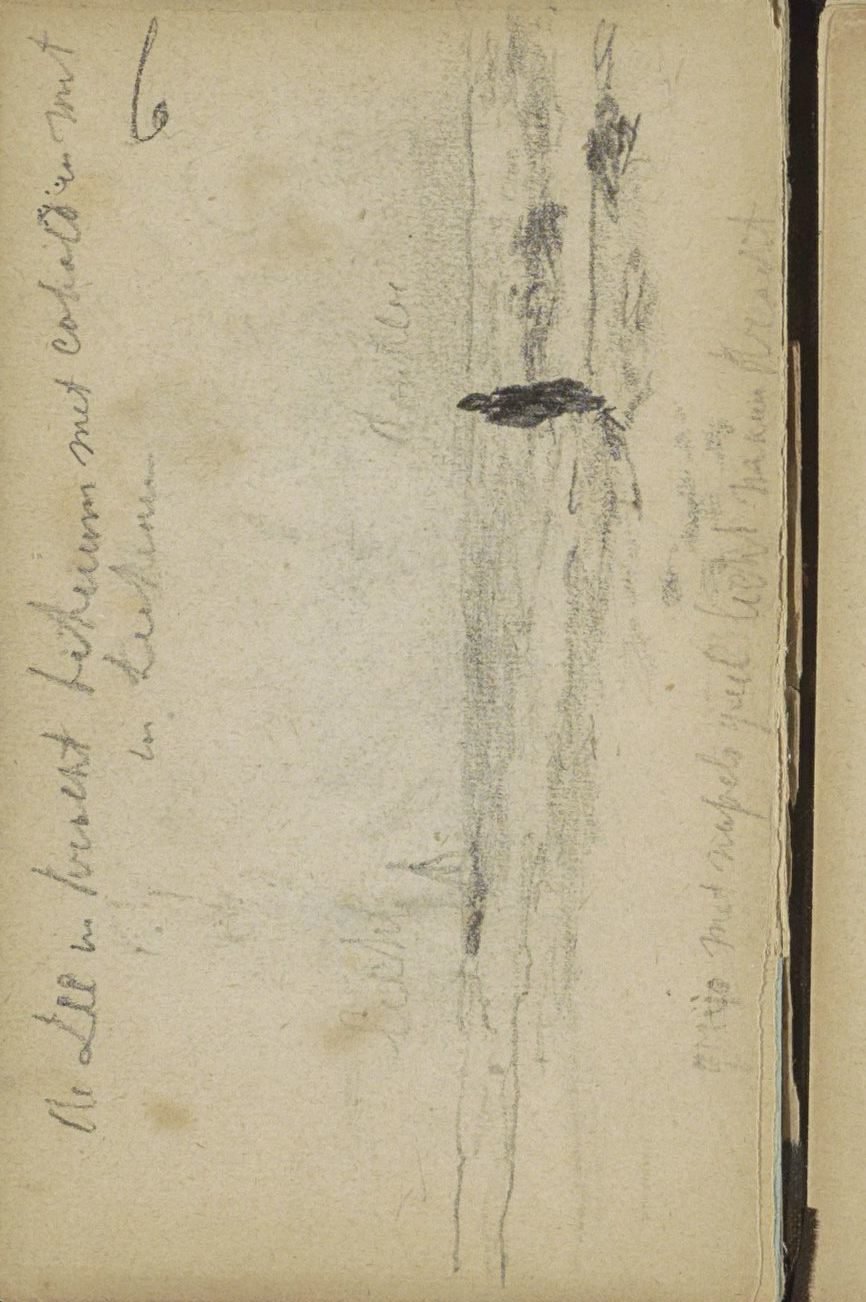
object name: sketchbook leaf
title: Zeegezicht met een figuur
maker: johan hendrik weissenbruch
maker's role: draughtsman, painter, print maker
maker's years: 1824-1903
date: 1834-1903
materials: paper, pencil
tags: sea (seascape) (+ landscape with figures, staffage)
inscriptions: annotation: ‘de zee in kracht [...] met cobald en wit/ in teekenen/ licht/ donker/ grijs met napels geel licht [...]’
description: De figuur staat aan de vloedlijn. Op zee is een zeilboot te zien. Blad 1 verso uit een schetsboek met 32 bladen.